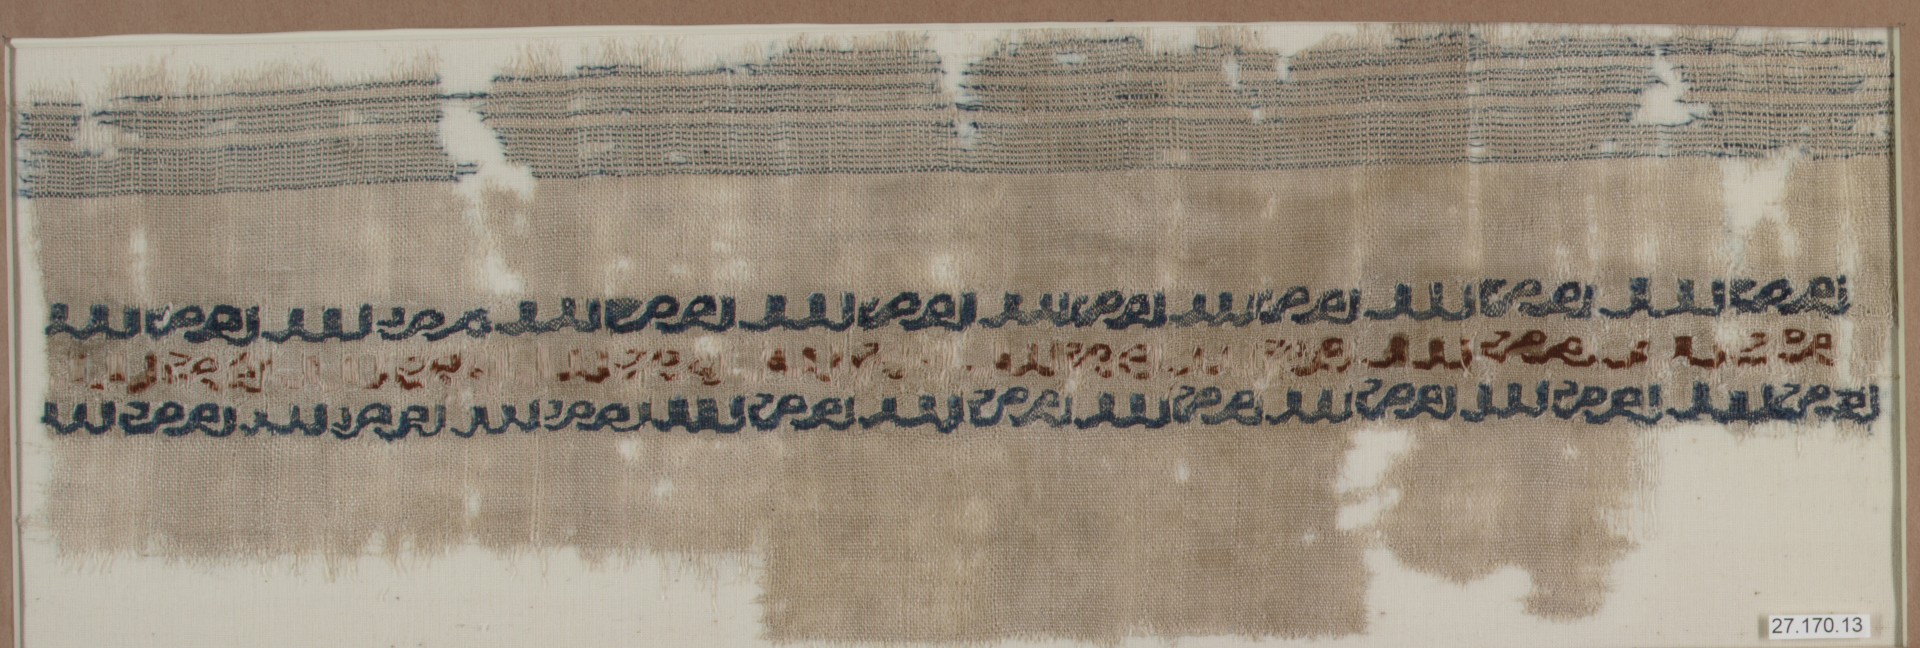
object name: textile fragment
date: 1101-1200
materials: linen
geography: egypt